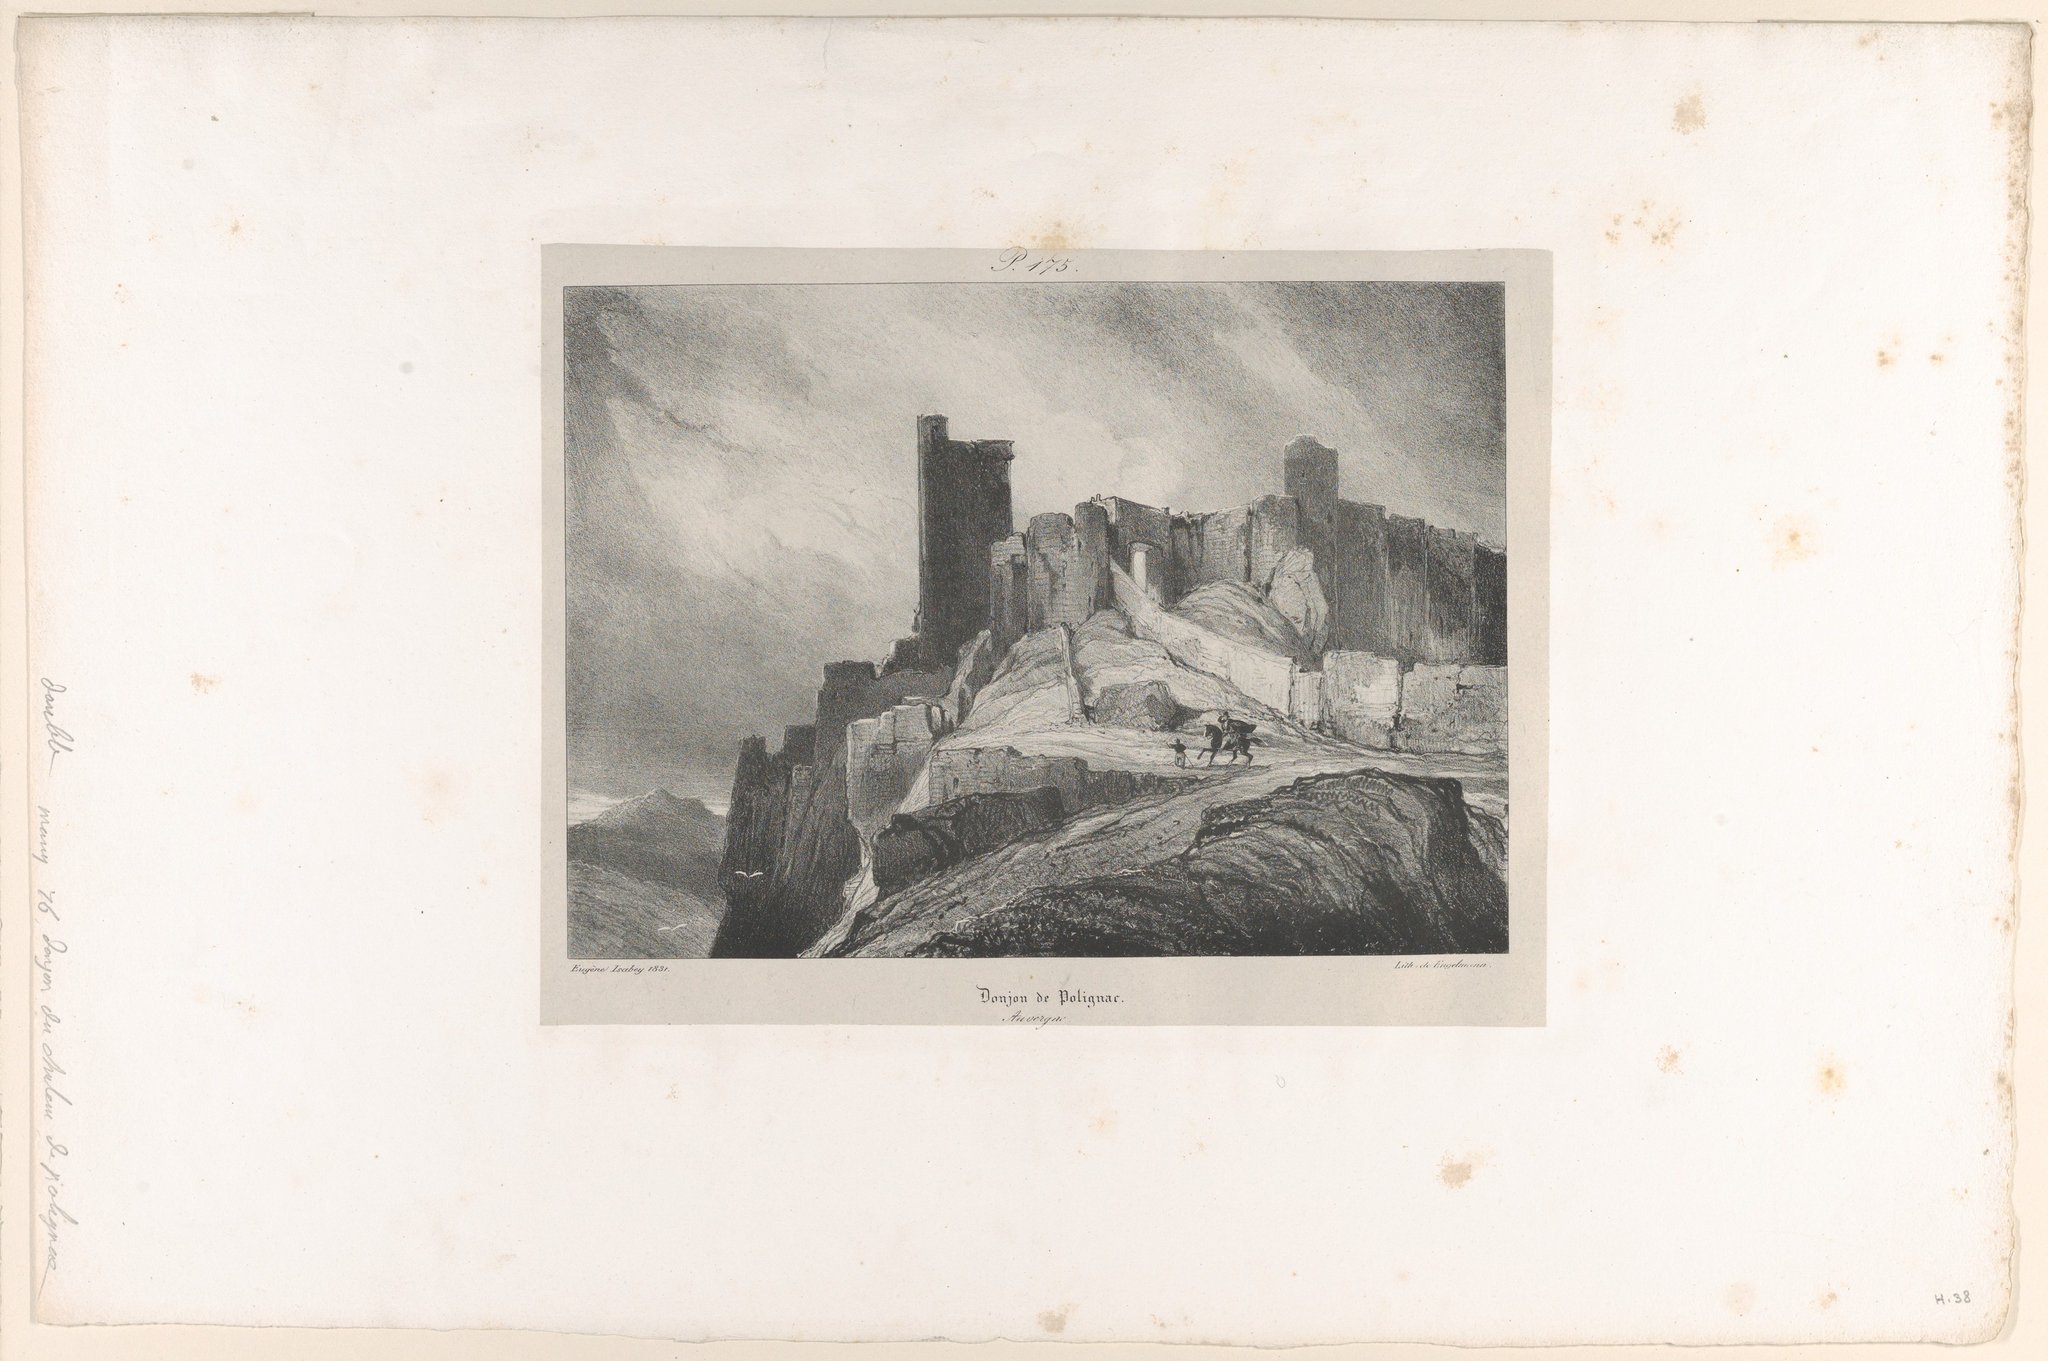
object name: print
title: The Dungeon of Polignac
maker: eugène isabey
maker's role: artist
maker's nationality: french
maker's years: 1803-1886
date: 1831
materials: paper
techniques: printmaking, lithograph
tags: horses,mountains